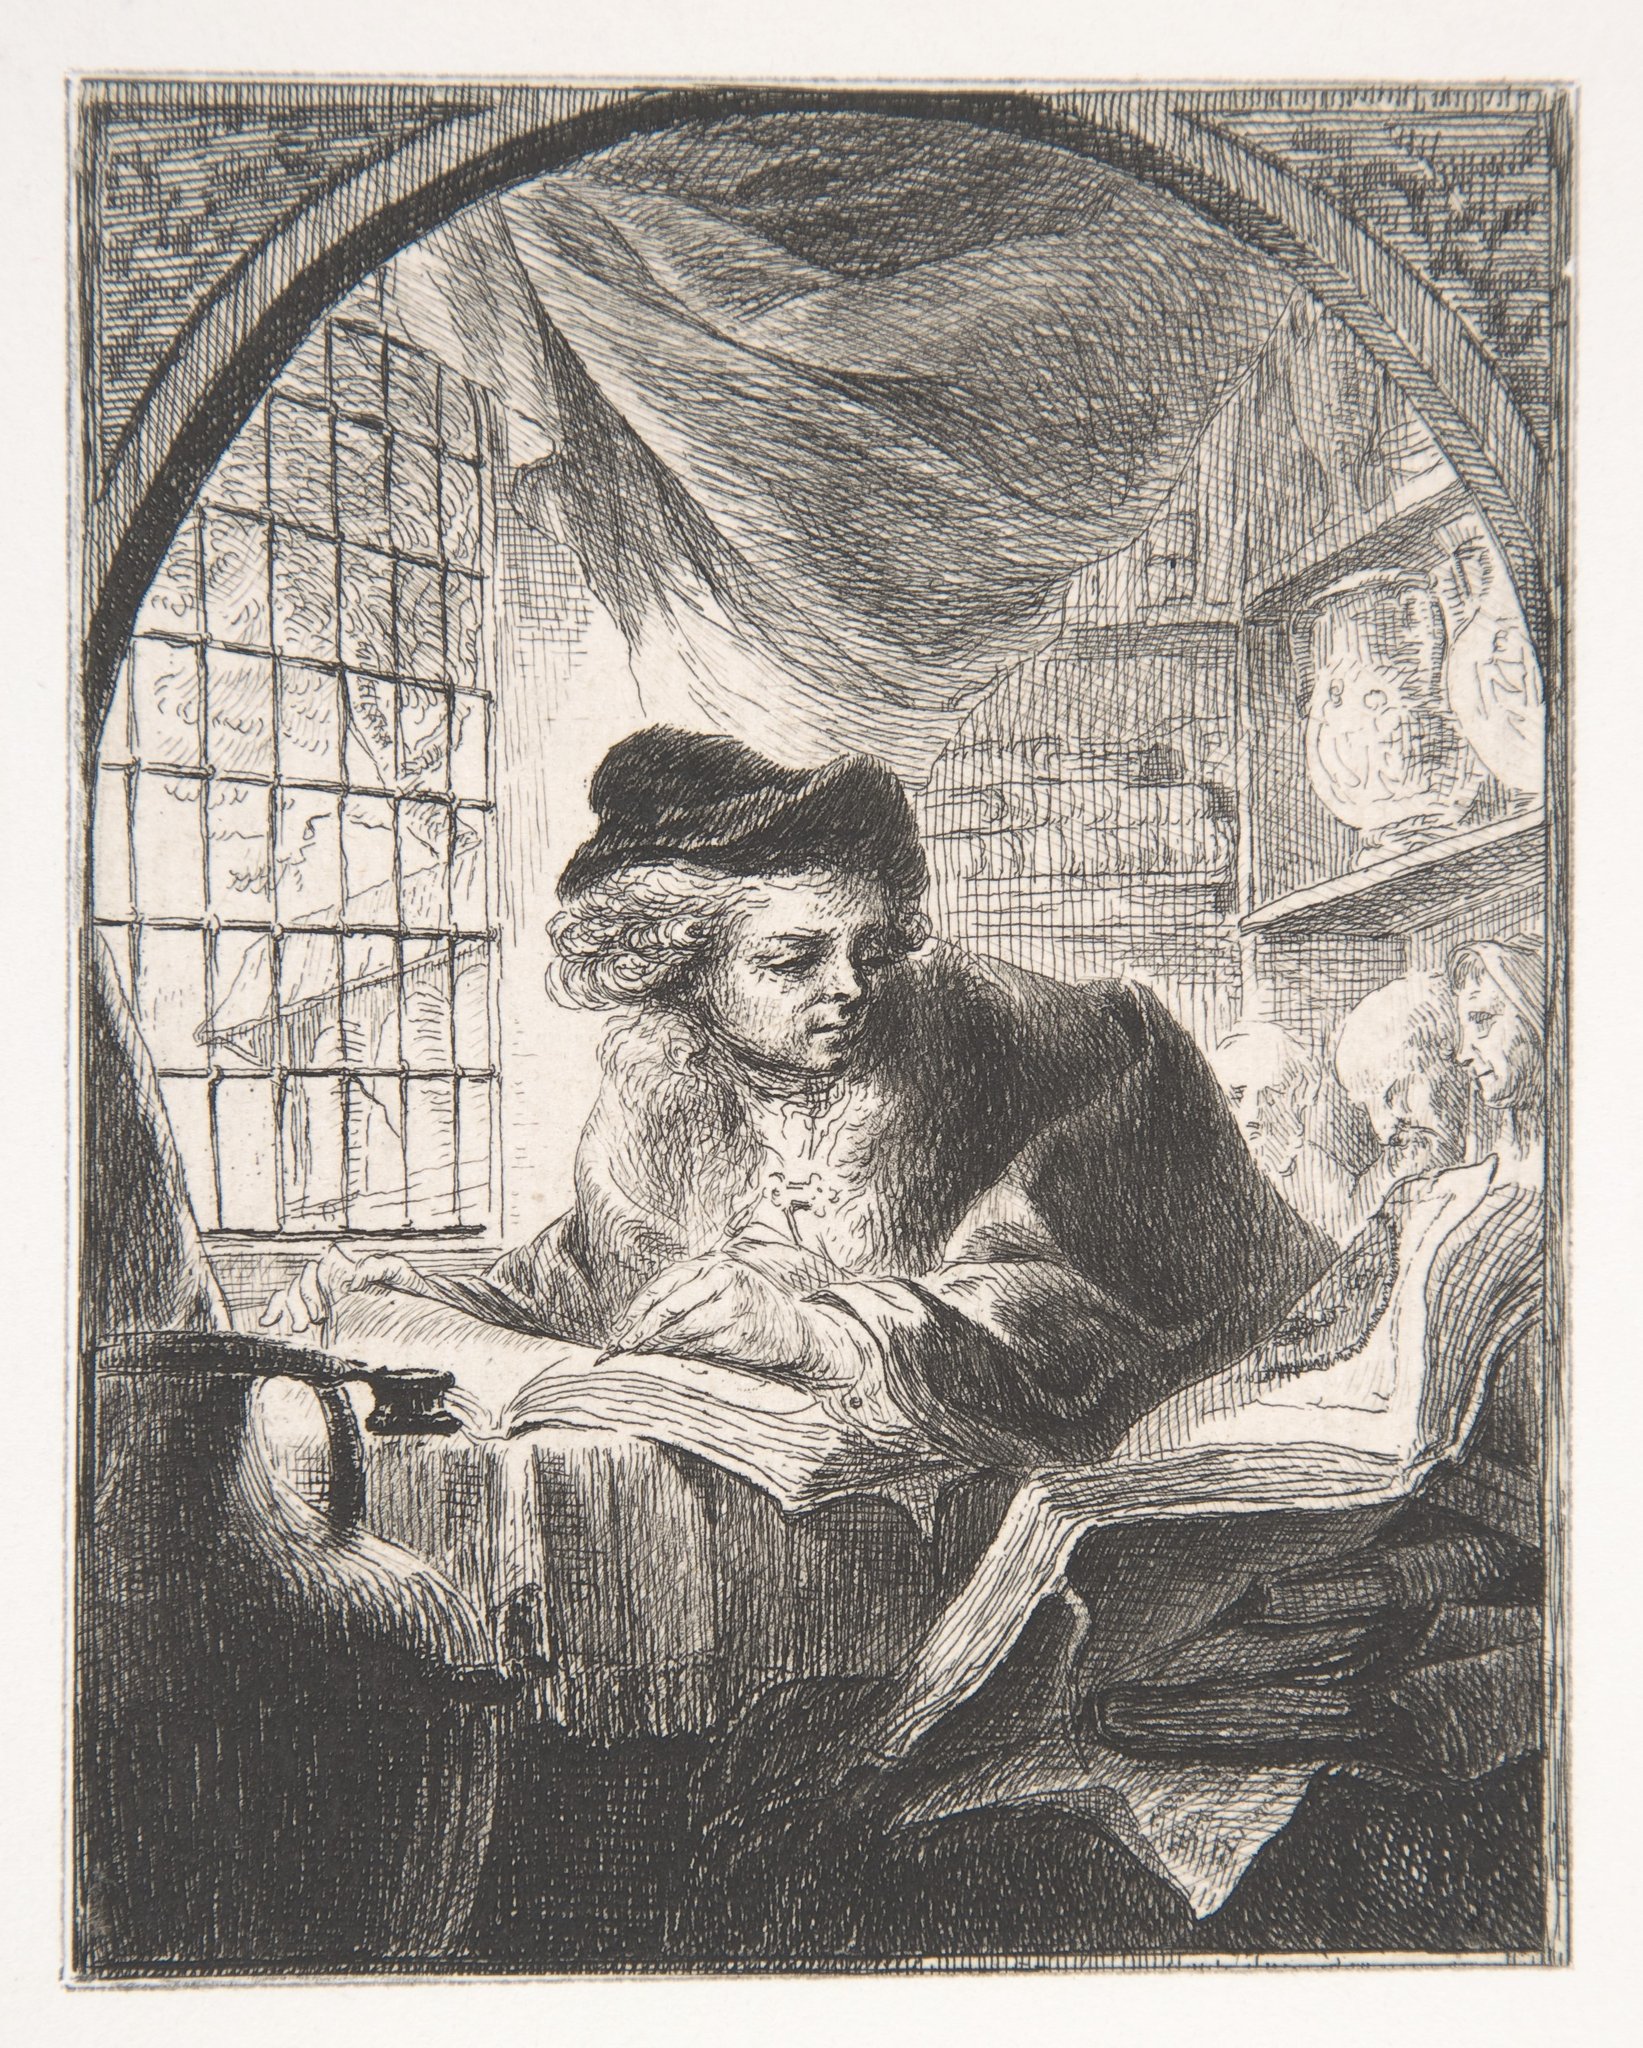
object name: print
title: Young Man Writing and Reading from Large Volume at His Left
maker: baron dominique vivant denon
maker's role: artist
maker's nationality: french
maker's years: 1747-1825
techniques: etching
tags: men,reading,writing